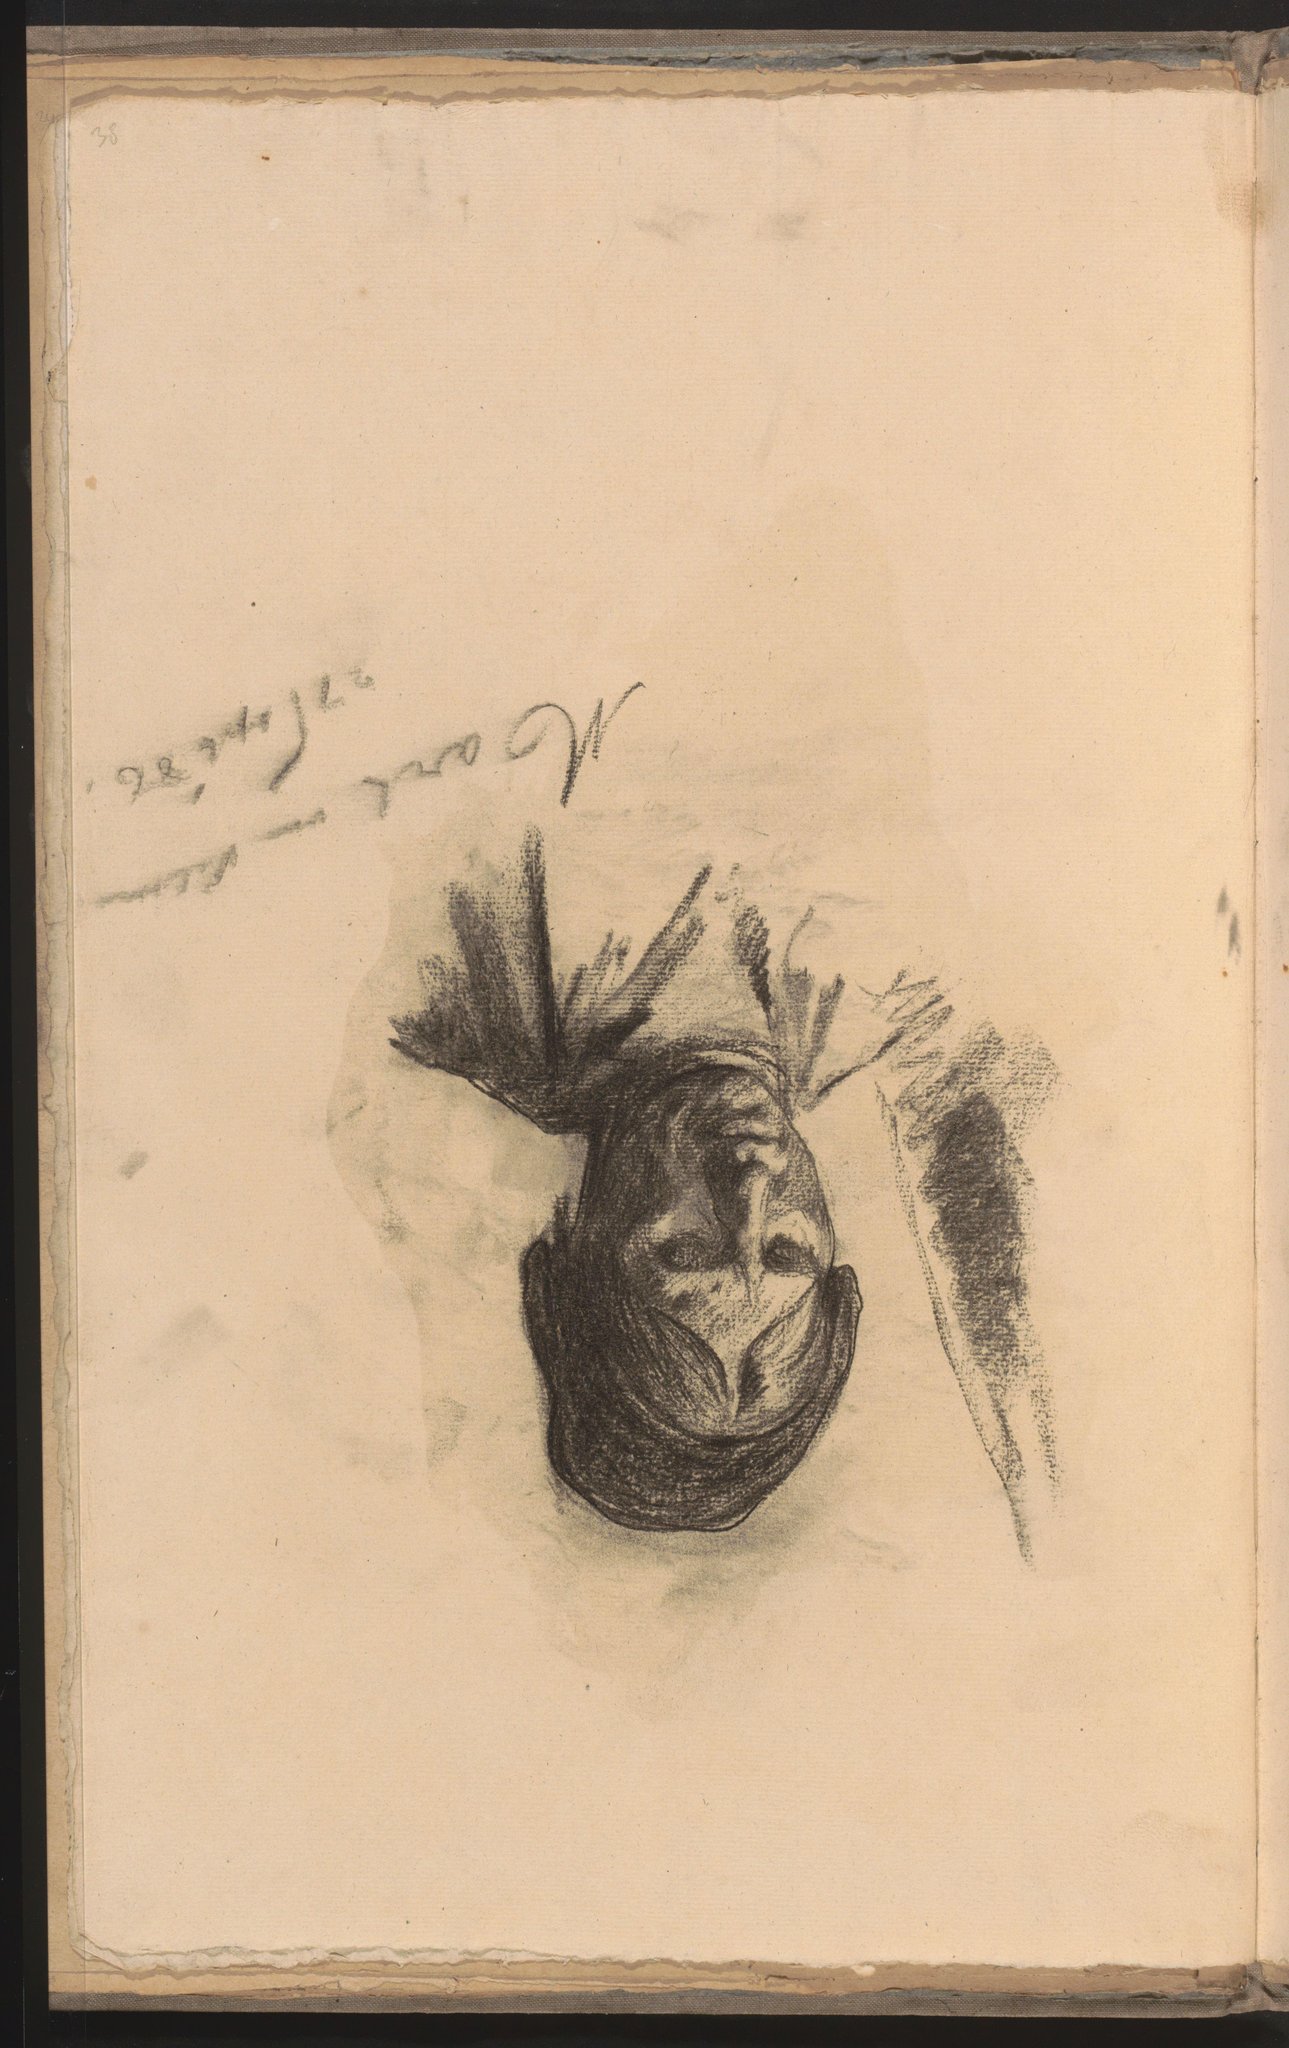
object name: sketchbook leaf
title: Portret van een vrouw die omlaag kijkt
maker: willem witsen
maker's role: draughtsman, painter, print maker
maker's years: 1860-1923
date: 1886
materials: chalk, paper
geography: ewijkshoeve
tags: adult woman, looking downwards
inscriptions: name: ‘Mart van [...]’, date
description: Pagina 38 uit een schetsboek met 38 bladen betekend rond de Ewijkshoeve.